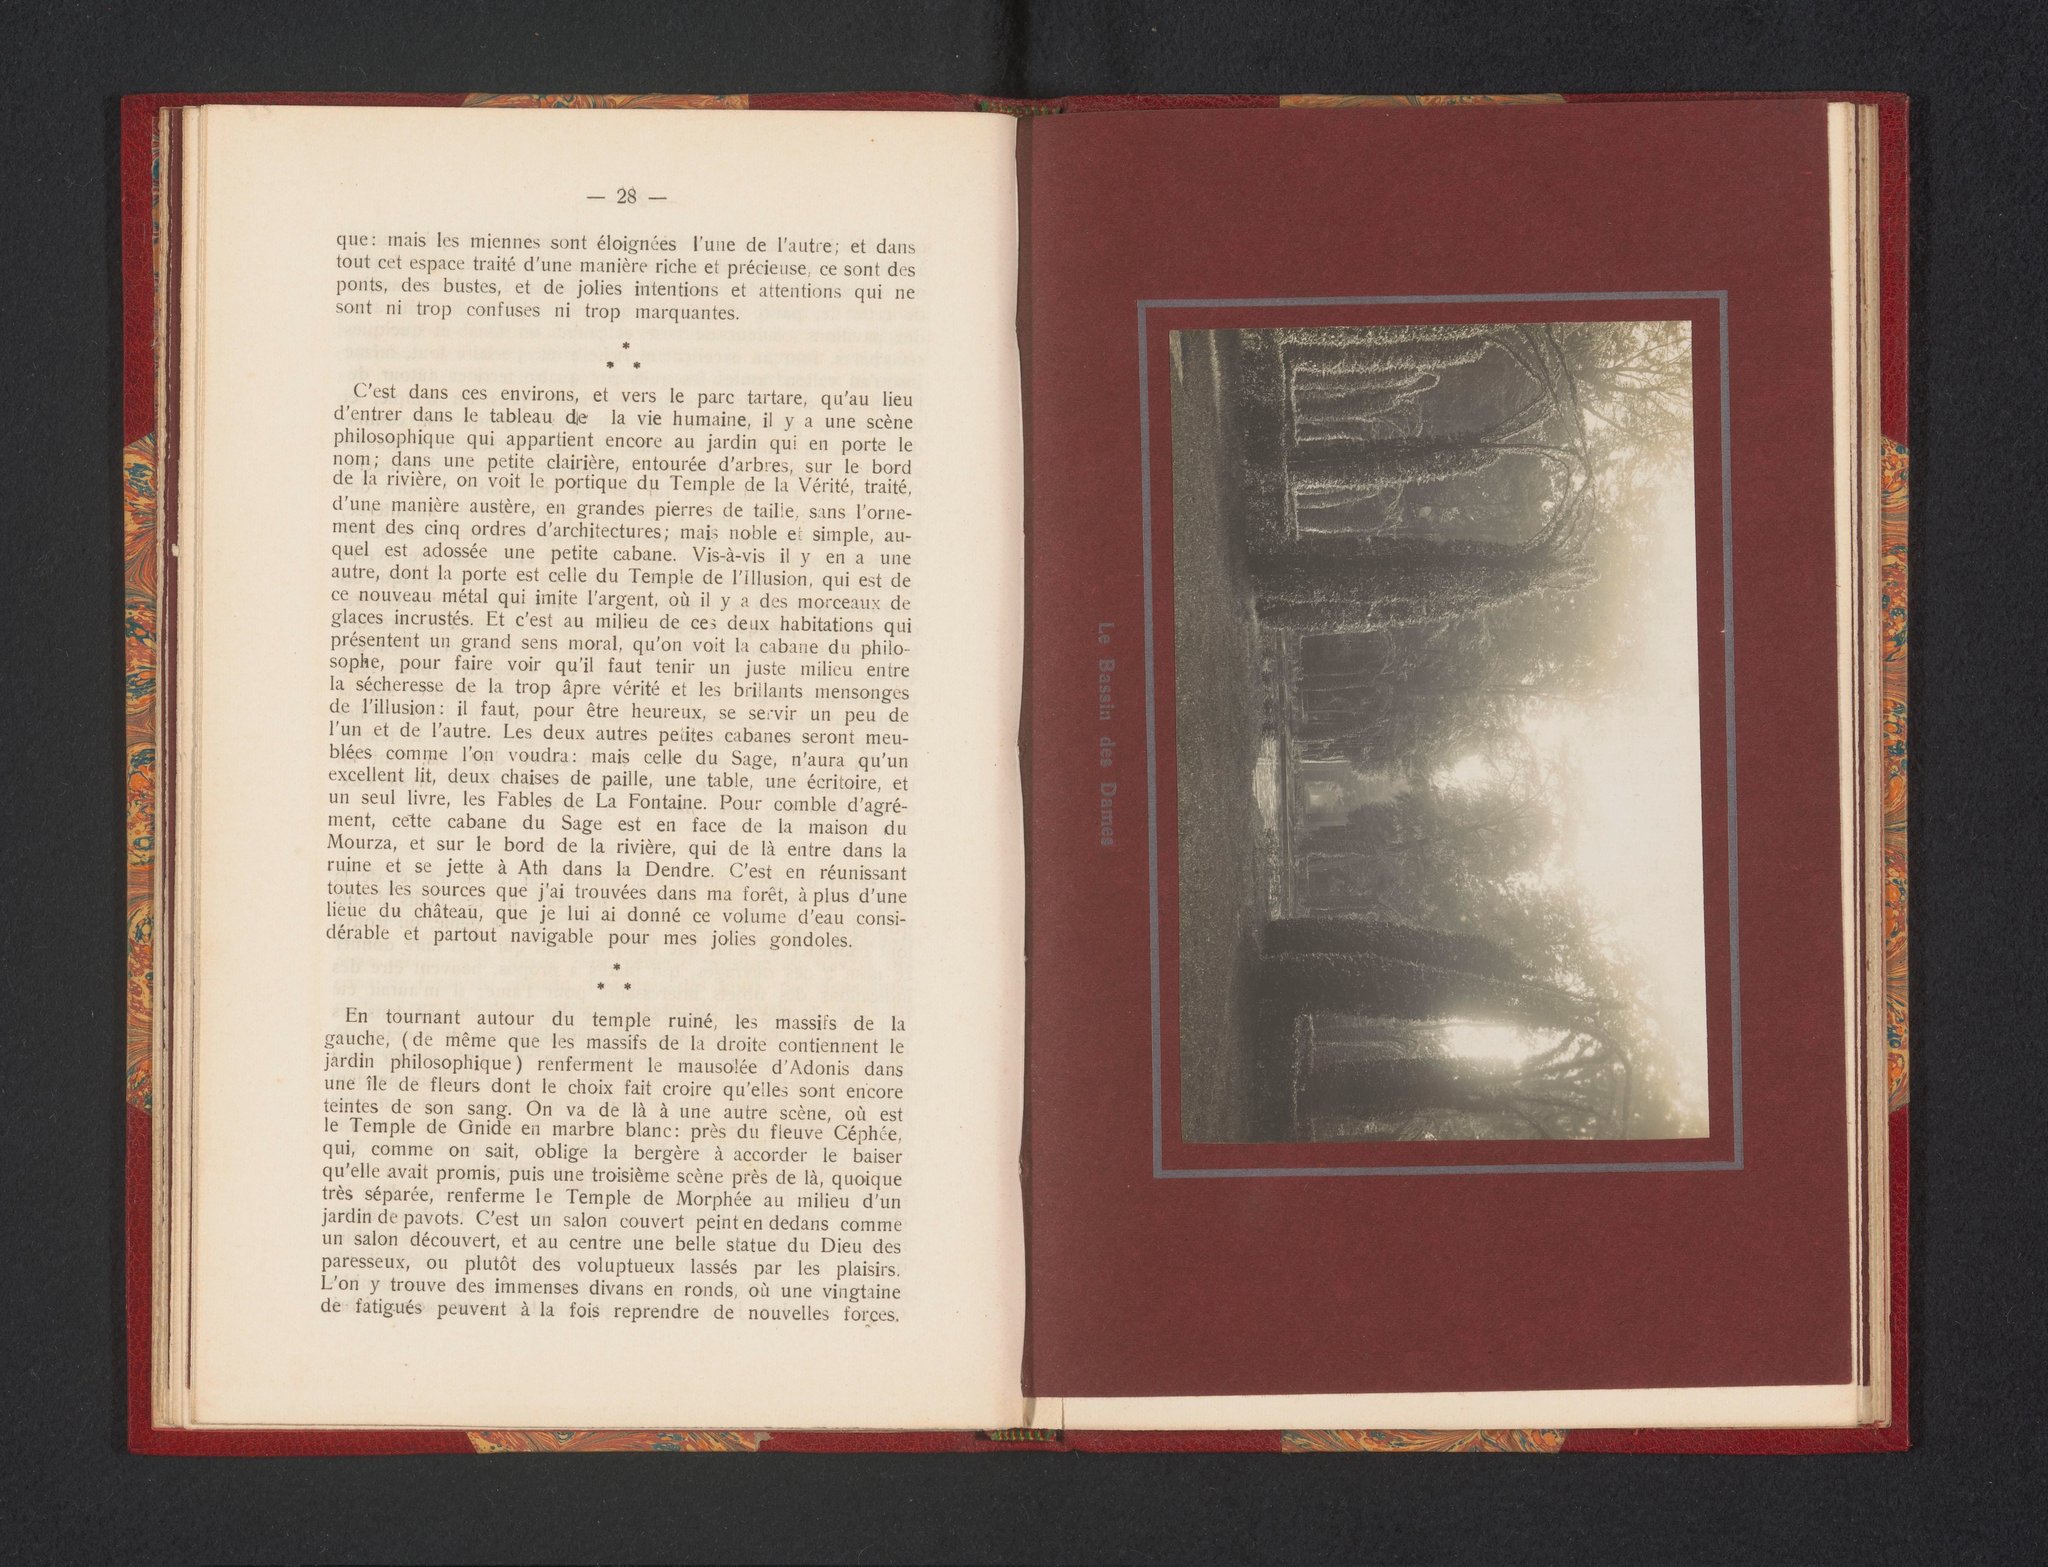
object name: page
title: Le Bassin des Dames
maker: coppin-goisse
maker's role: printer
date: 1903-1908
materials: photographic support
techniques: gelatin silver print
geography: beloeil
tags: garden